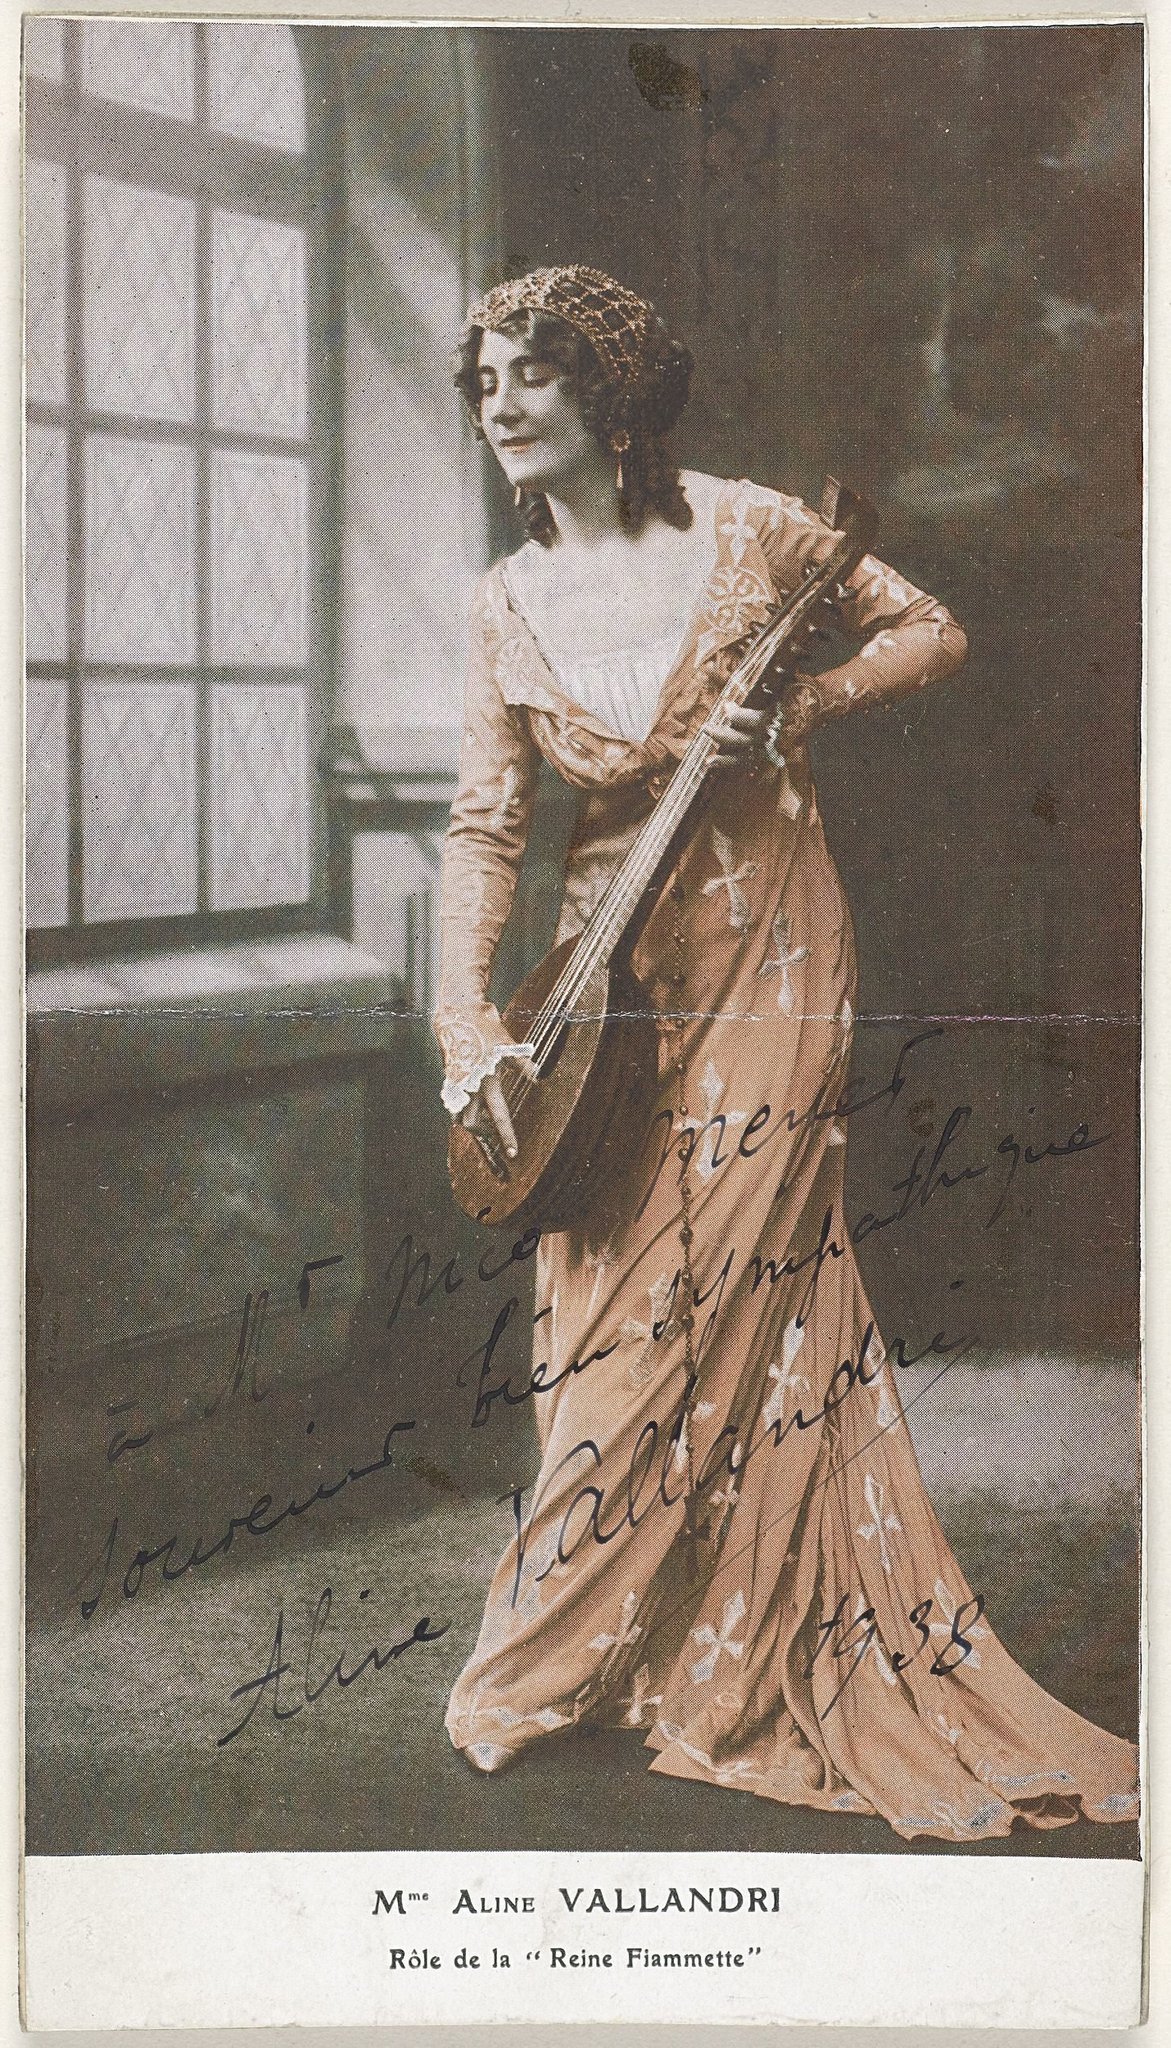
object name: photograph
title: Portret van Aline Vallandri als 'Reine Fiammette'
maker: Anonymous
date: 1938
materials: photographic support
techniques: photochemical processes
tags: aline vallandri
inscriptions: inscription: ‘a Mr Nice Menter souvenir bien sympathique Aline Vallandre 1938’